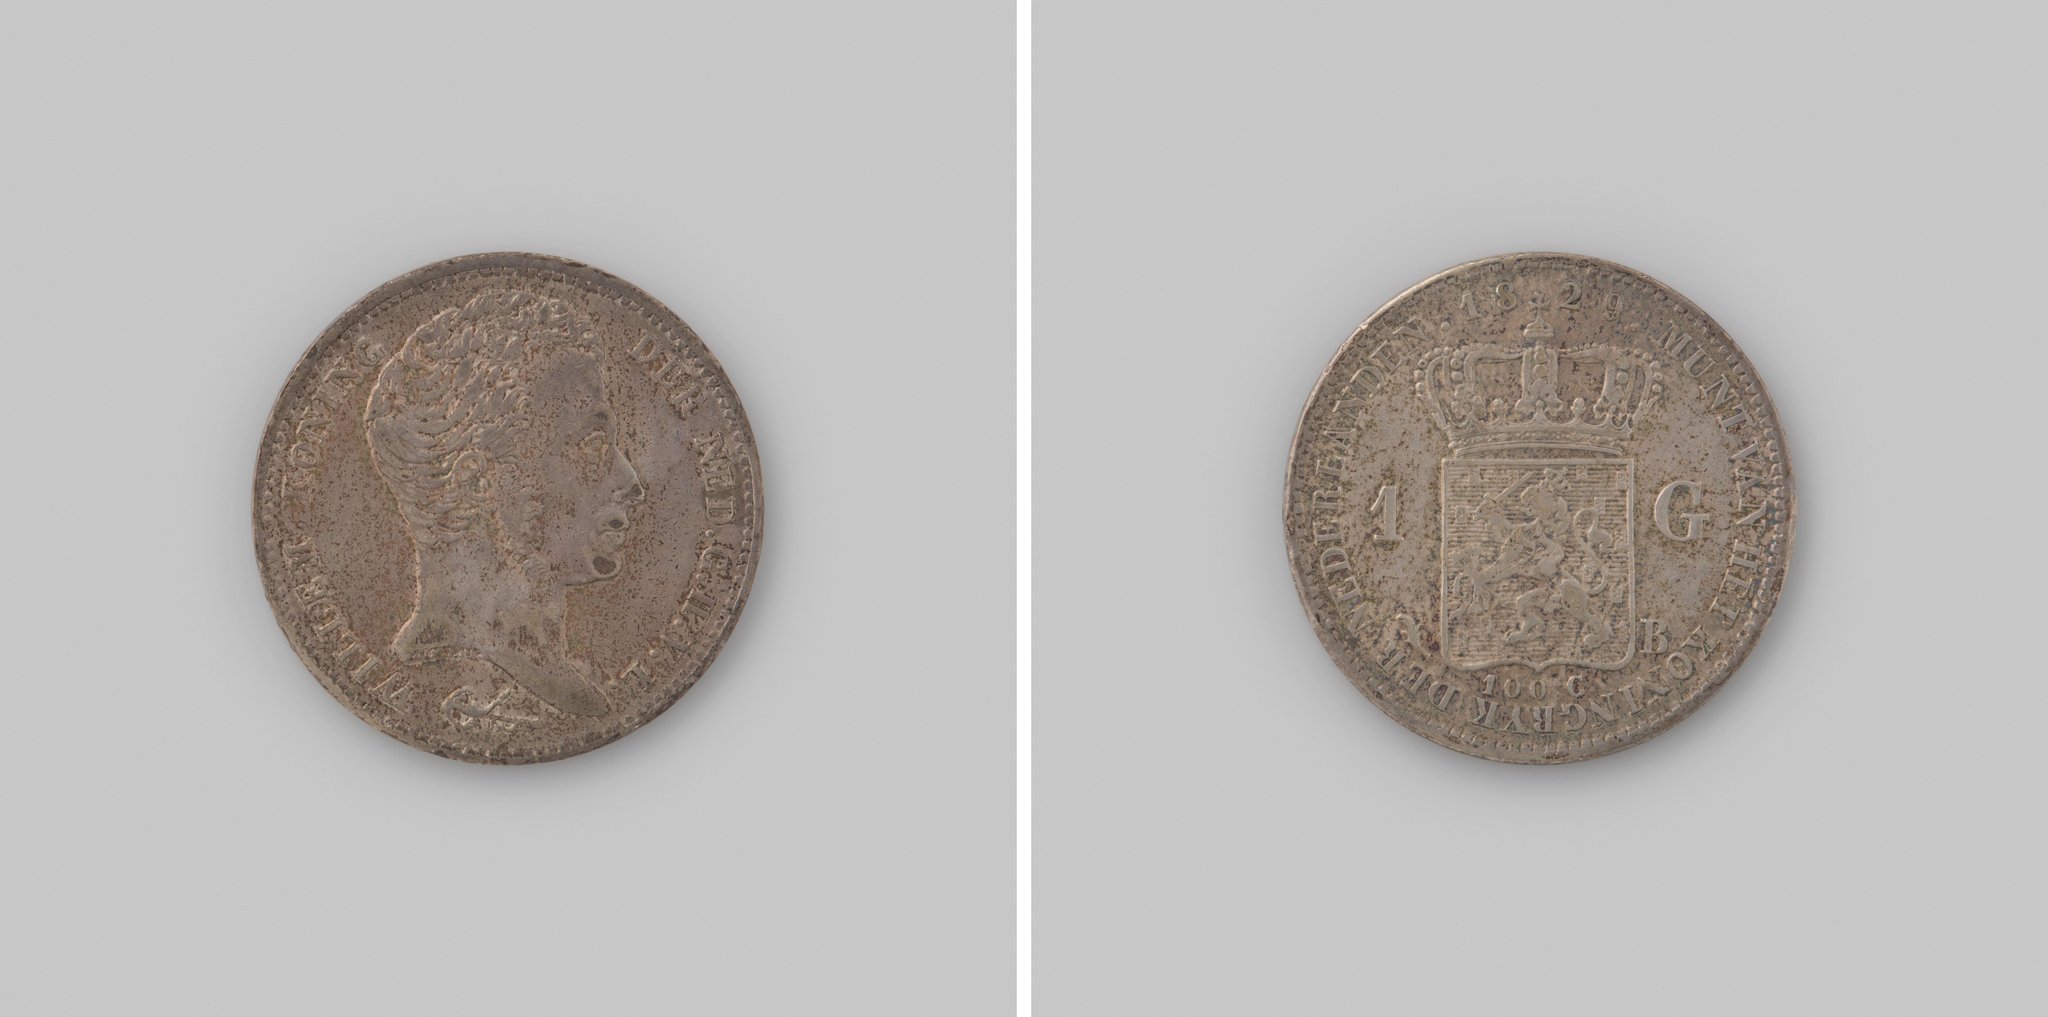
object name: coin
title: Nederlandse gulden, 1829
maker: william i of the netherlands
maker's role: koning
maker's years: 1772-1843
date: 1829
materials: silver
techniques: striking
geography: brussels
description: Zilveren munt. Voorzijde: borstbeeld naar rechts. Keerzijde: tussen waarde-aanduiding 1 G gekroond rijkswapenschild. Jaartal boven kroon. Randschrift.